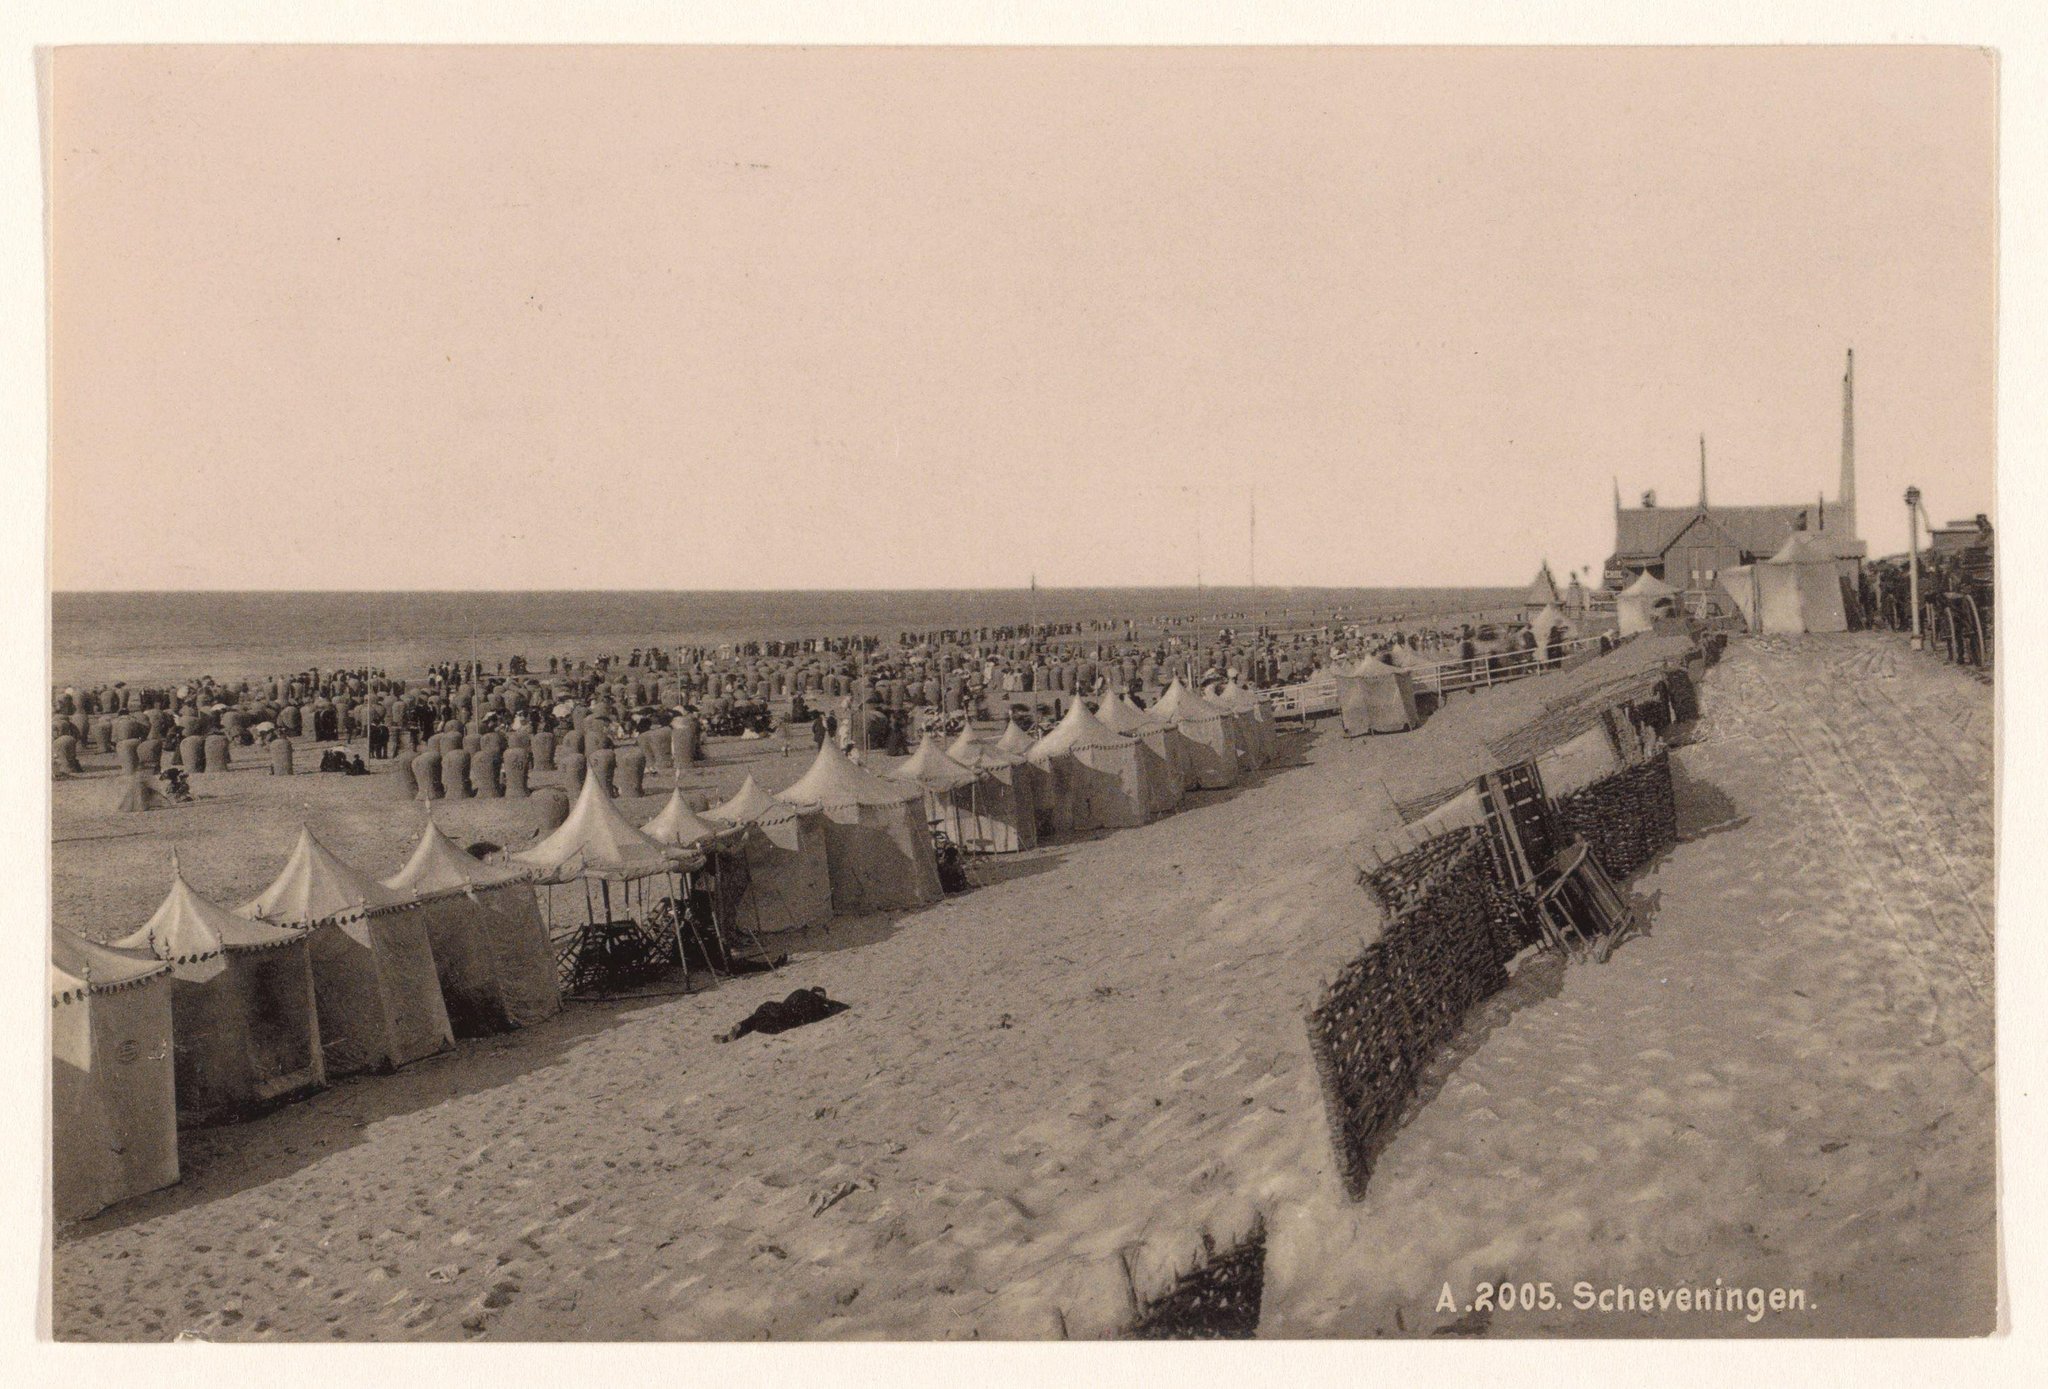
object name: photomechanical print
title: Scheveningen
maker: Anonymous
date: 1896-1910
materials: paper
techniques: photograph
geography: scheveningen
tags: beach (as place of recreation)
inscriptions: inscription: ‘A.2005. Scheveningen.’, stamp: ‘Originalaufnahme/ von/ Dr. E. Mertens & Cie Berlin, W. 50./ Verlag: Haagsche Boekhandel- en Uitgevers-Maatschappij/ Gesetzlich geschützt 1896.’